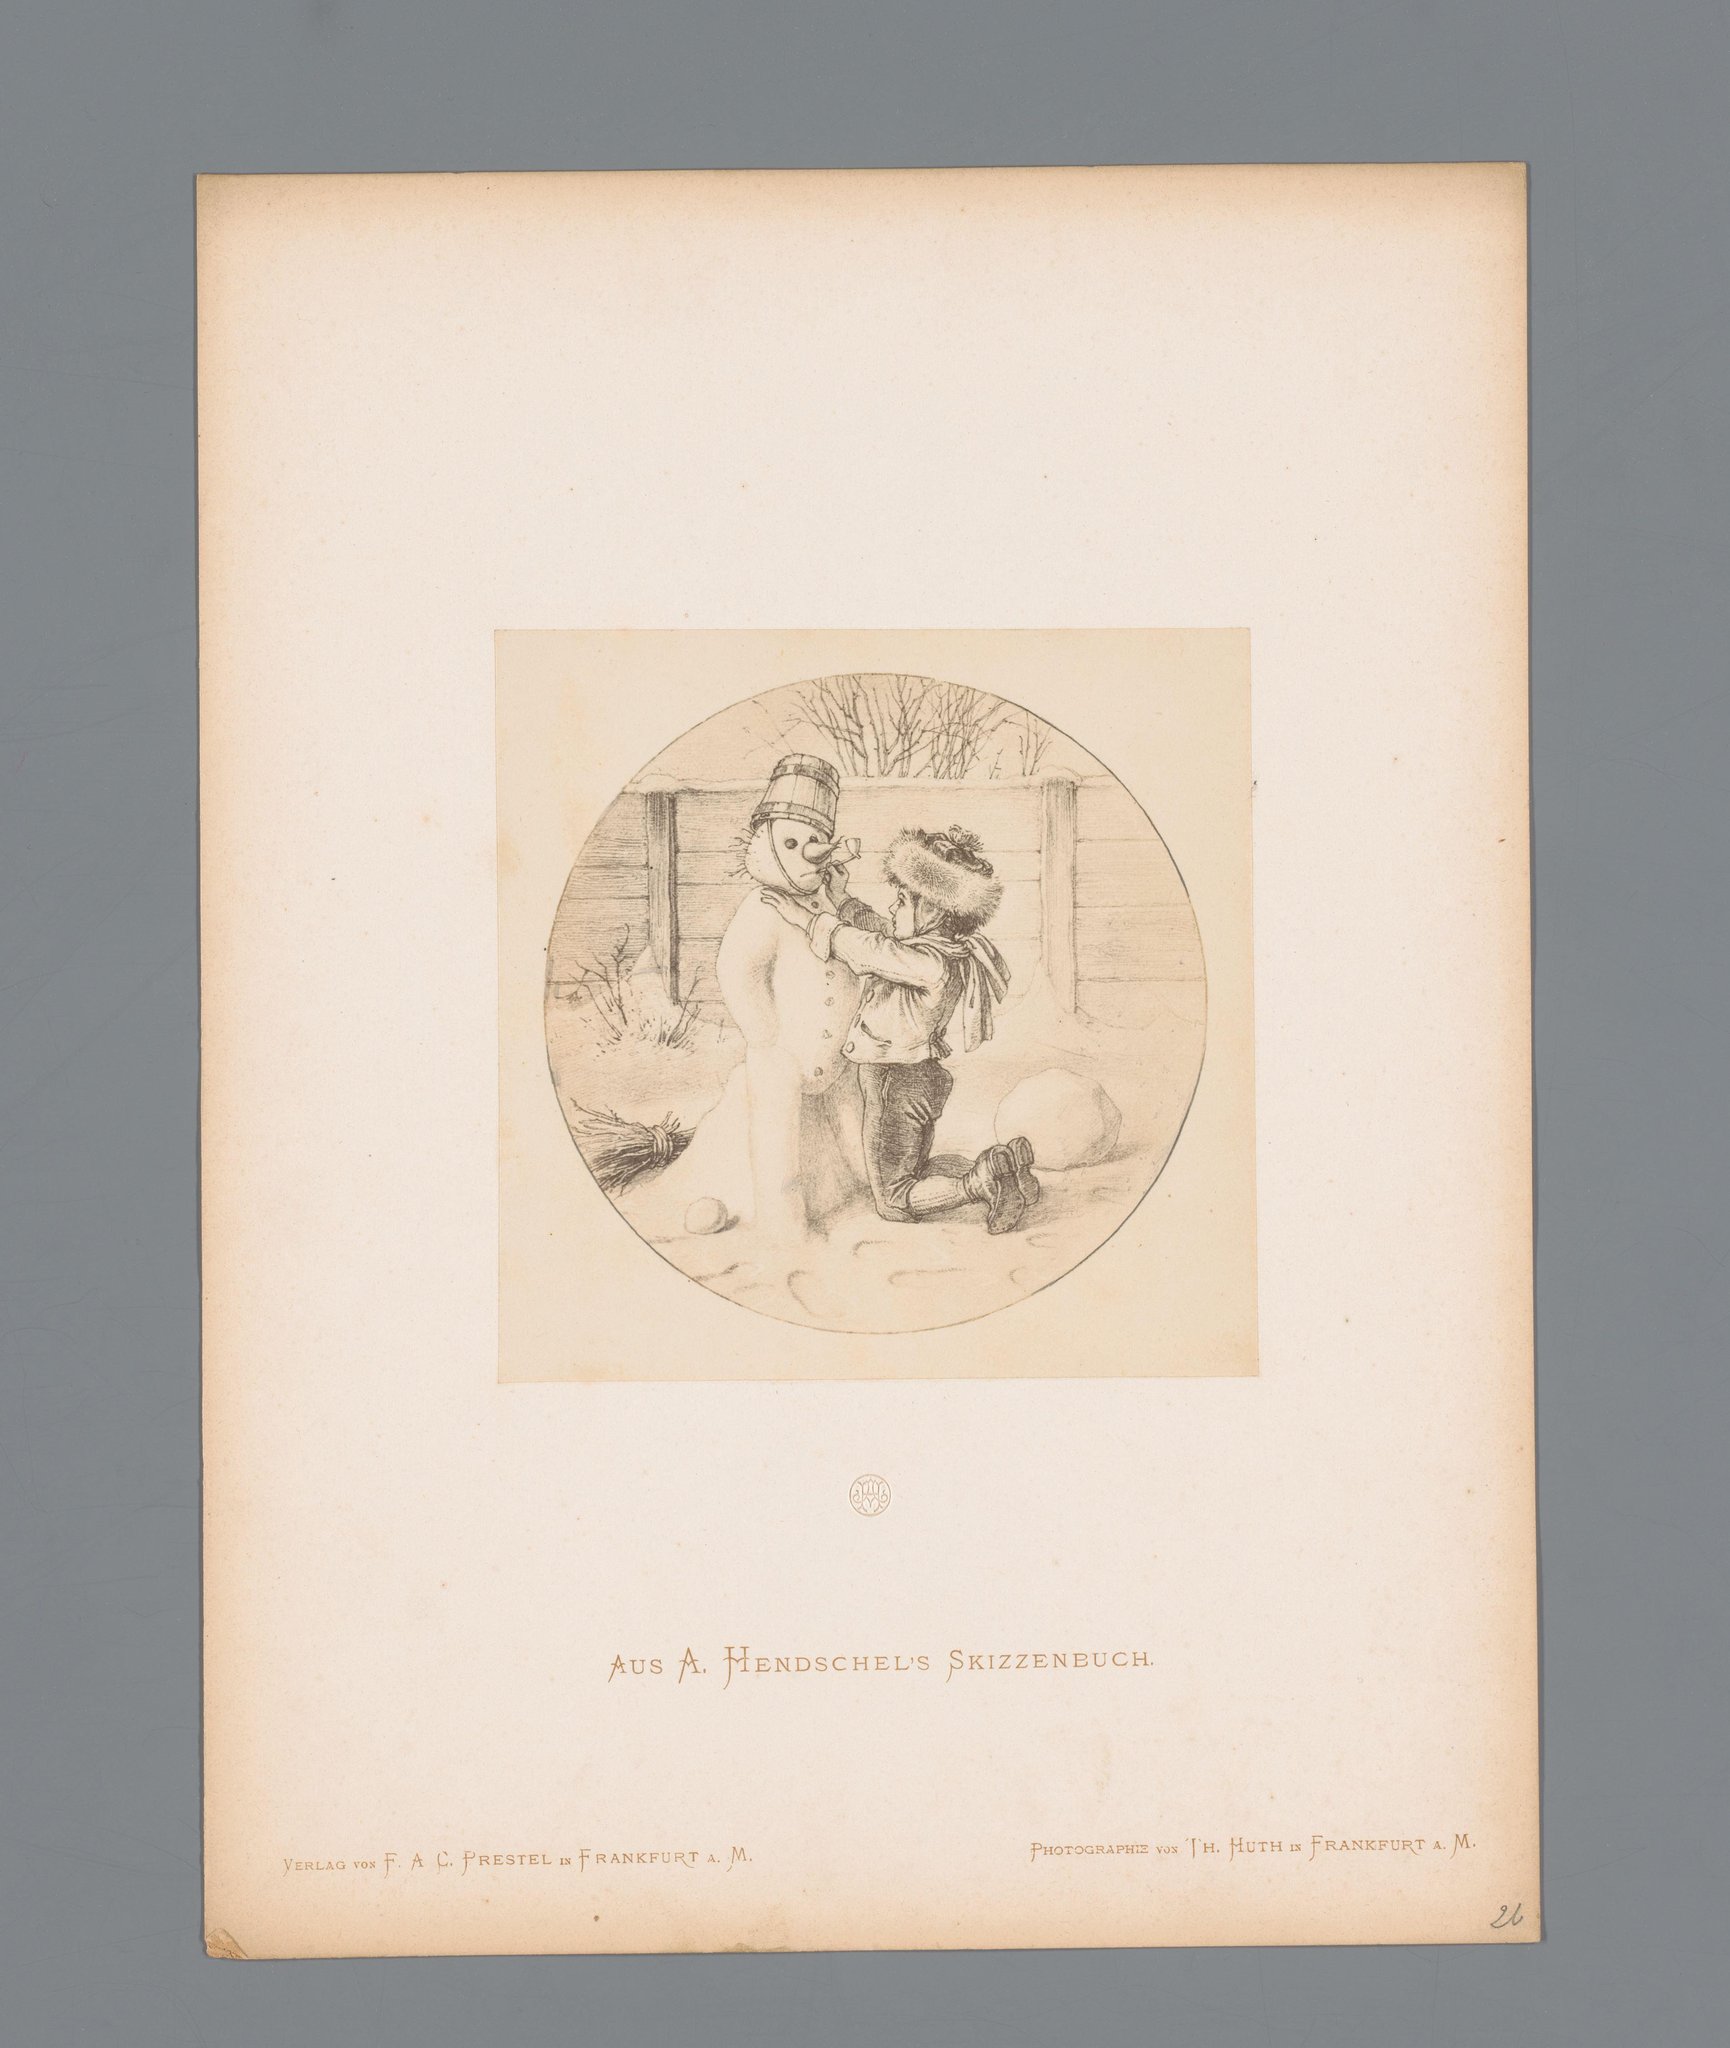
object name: photograph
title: Aus A. Hendschel's Skizzenbuch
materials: photographic support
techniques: albumen print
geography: frankfurt am main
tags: (making a) snowman, toddler (male)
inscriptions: number: ‘26’, monogram: ‘AH’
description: Deze foto maakt deel uit van een omslag met 50 foto's op 48 bladen, een lijst van afbeeldingen en een titelblad.